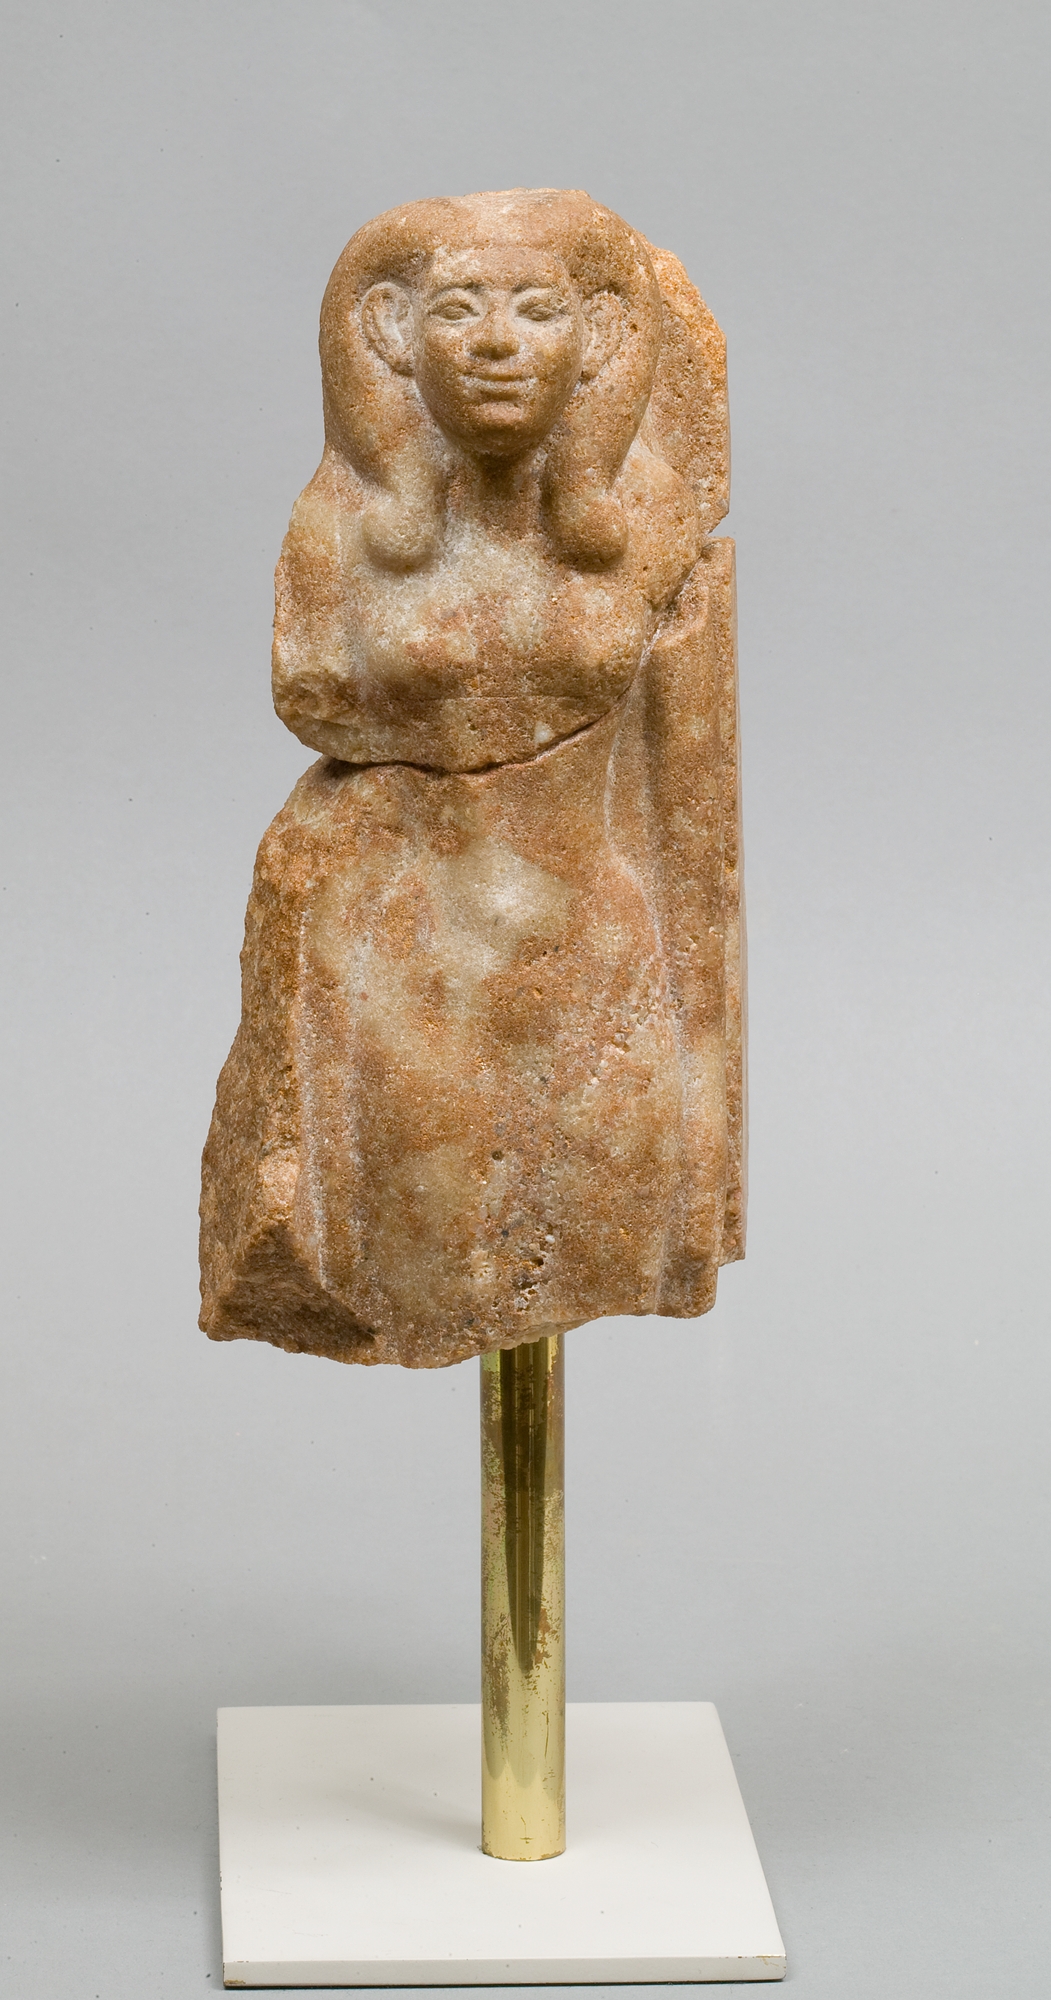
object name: statuette of a woman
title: Female figure from a group statue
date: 1981-1640 BCE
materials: quartzite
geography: egypt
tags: women